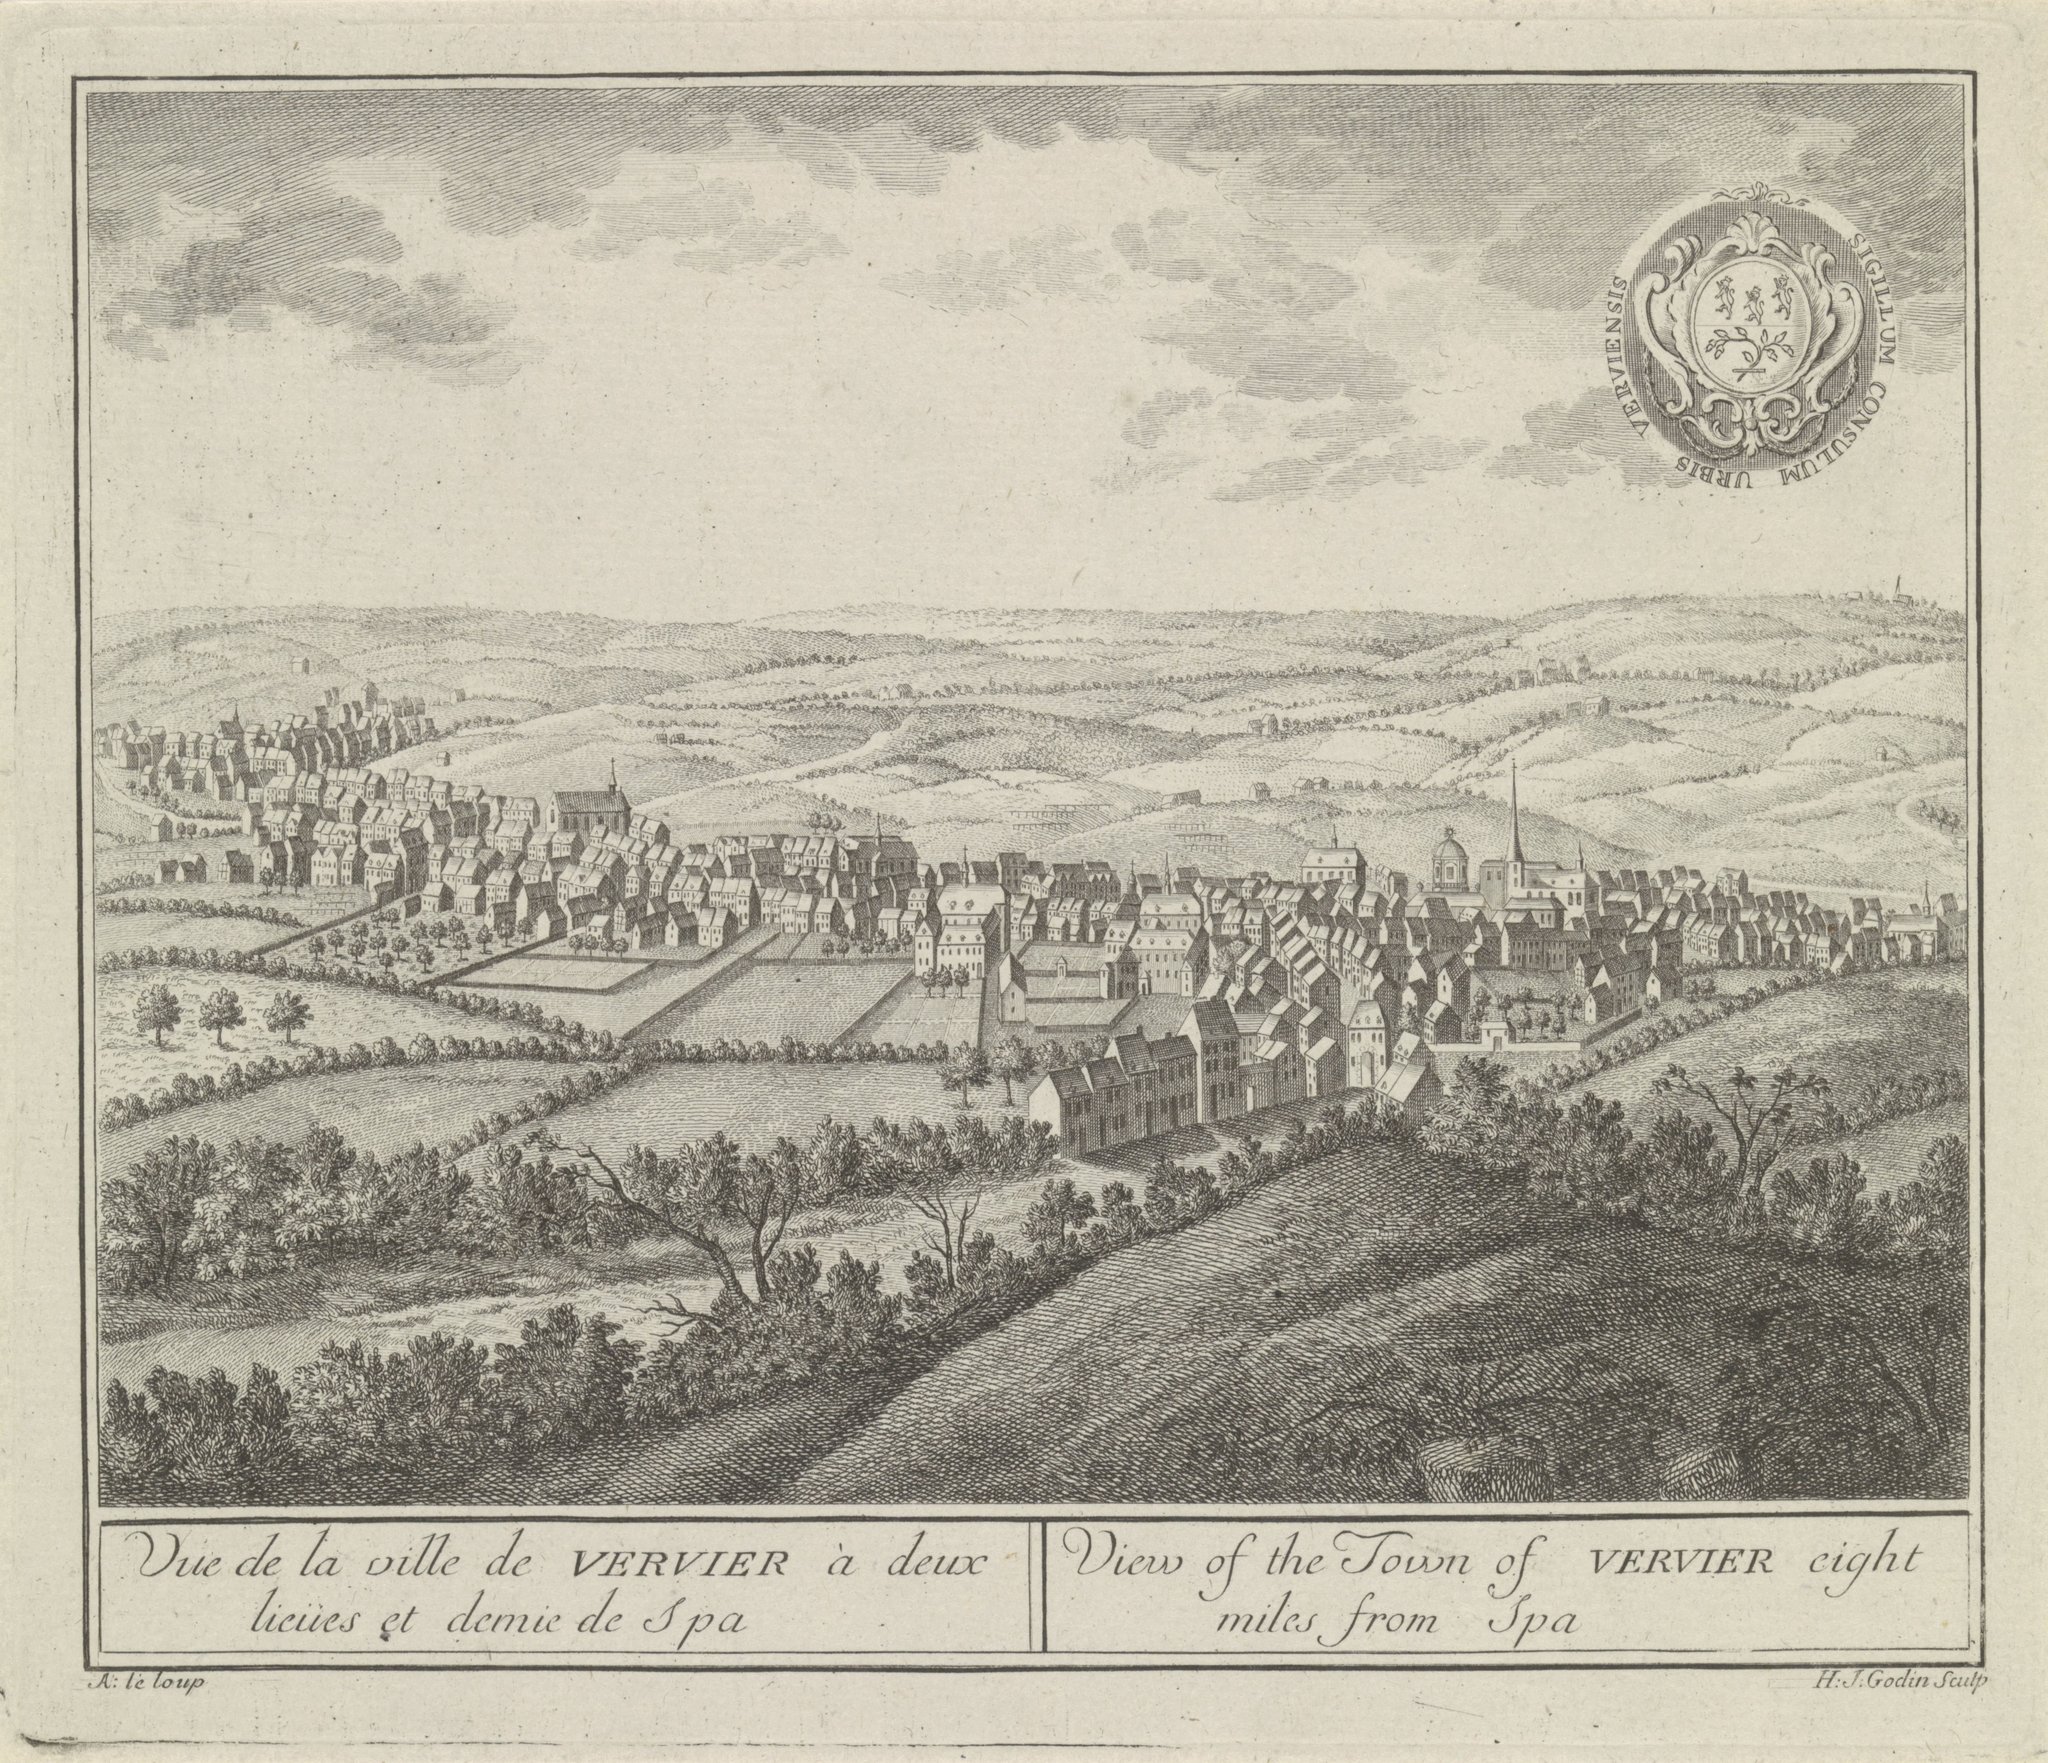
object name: print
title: Gezichten in en nabij Spa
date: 1778-1782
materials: paper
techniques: engraving, etching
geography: liège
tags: city-view in general; 'veduta'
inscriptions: collector's mark: Lugt 2228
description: Gezicht op de stad Verviers. Rechtsboven het wapenschild van Verviers. De prent is deel van een serie met landschappen in en nabij Spa